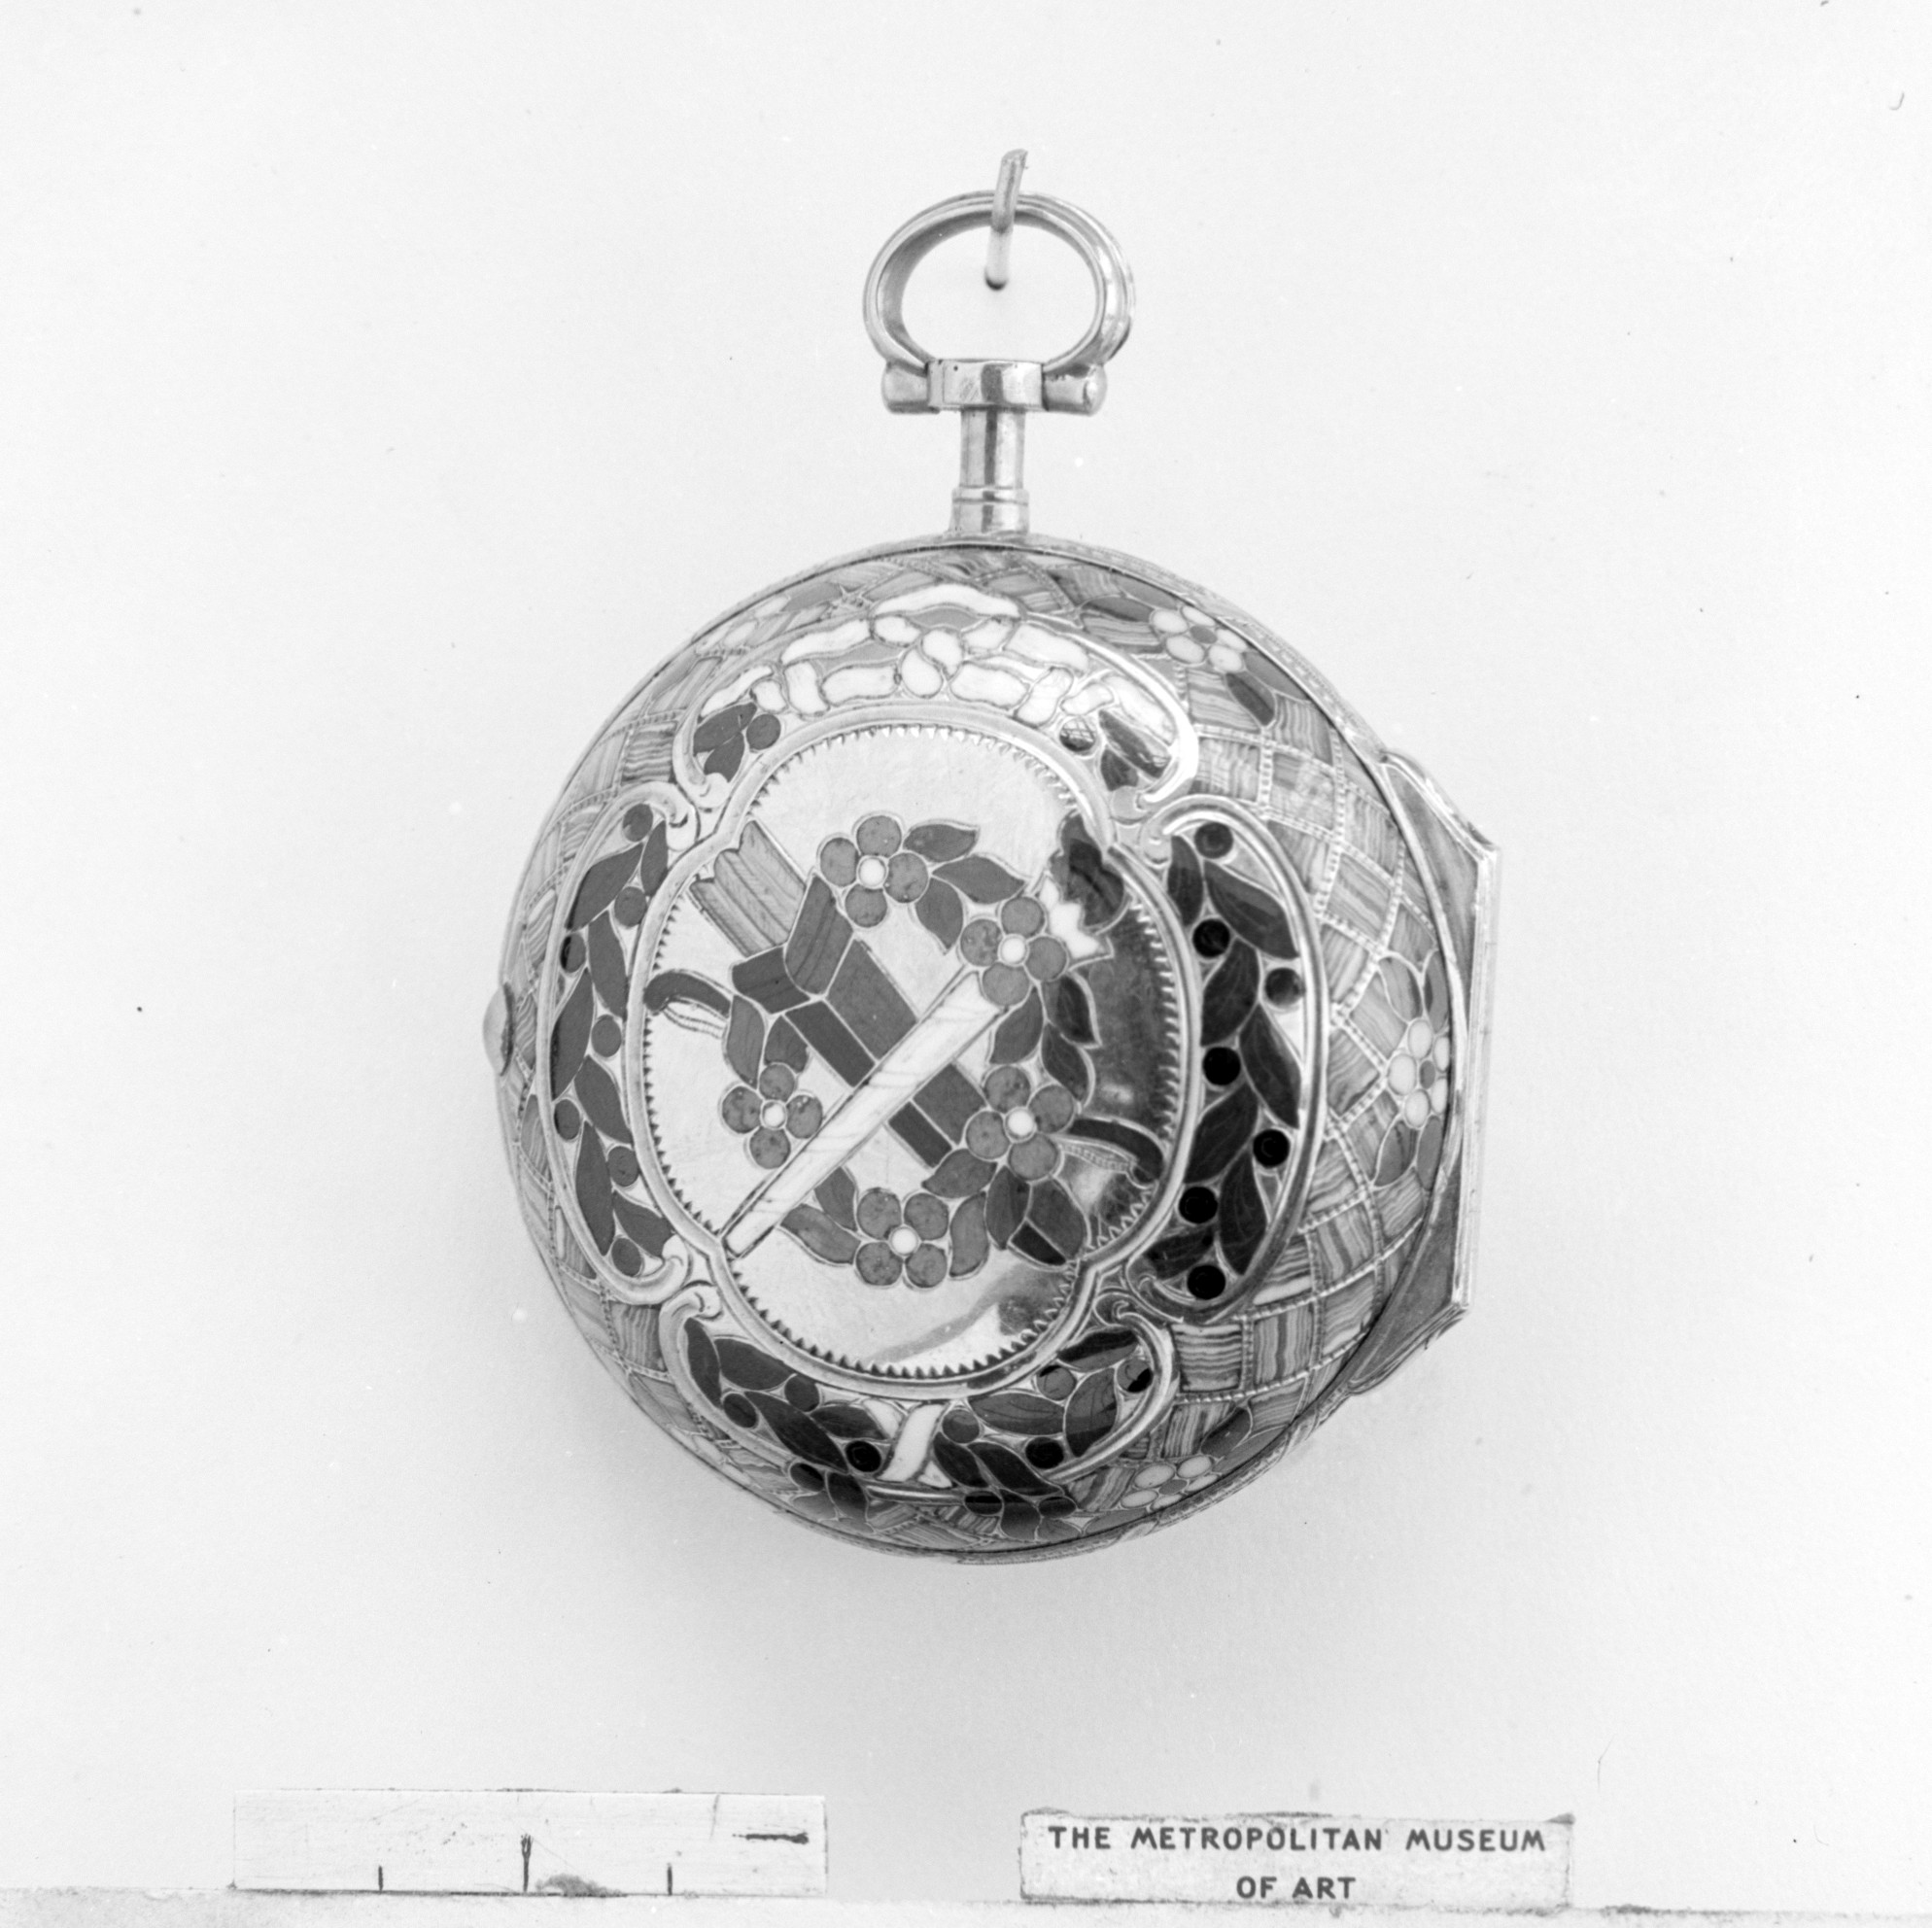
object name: watch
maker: pierre le roy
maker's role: maker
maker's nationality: french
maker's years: 1717-1785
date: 1770-1795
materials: enamel, gold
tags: garlands